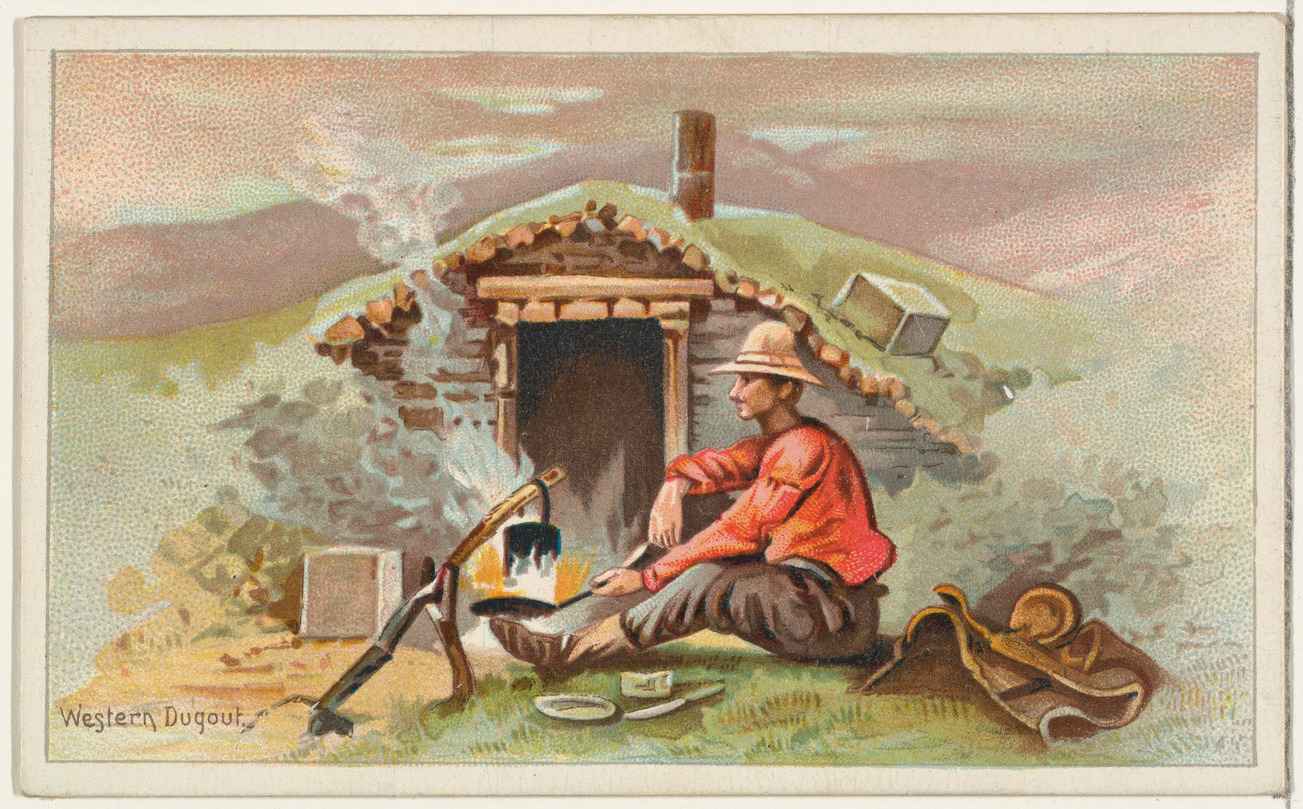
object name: print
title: Western Dugout, from the Habitations of Man series (N113) issued by W. Duke, Sons & Co. to promote Honest Long Cut Smoking and Chewing Tobacco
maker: the giles company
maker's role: artist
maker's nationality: american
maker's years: 1800-1900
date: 1890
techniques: color lithograph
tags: houses,men,fire